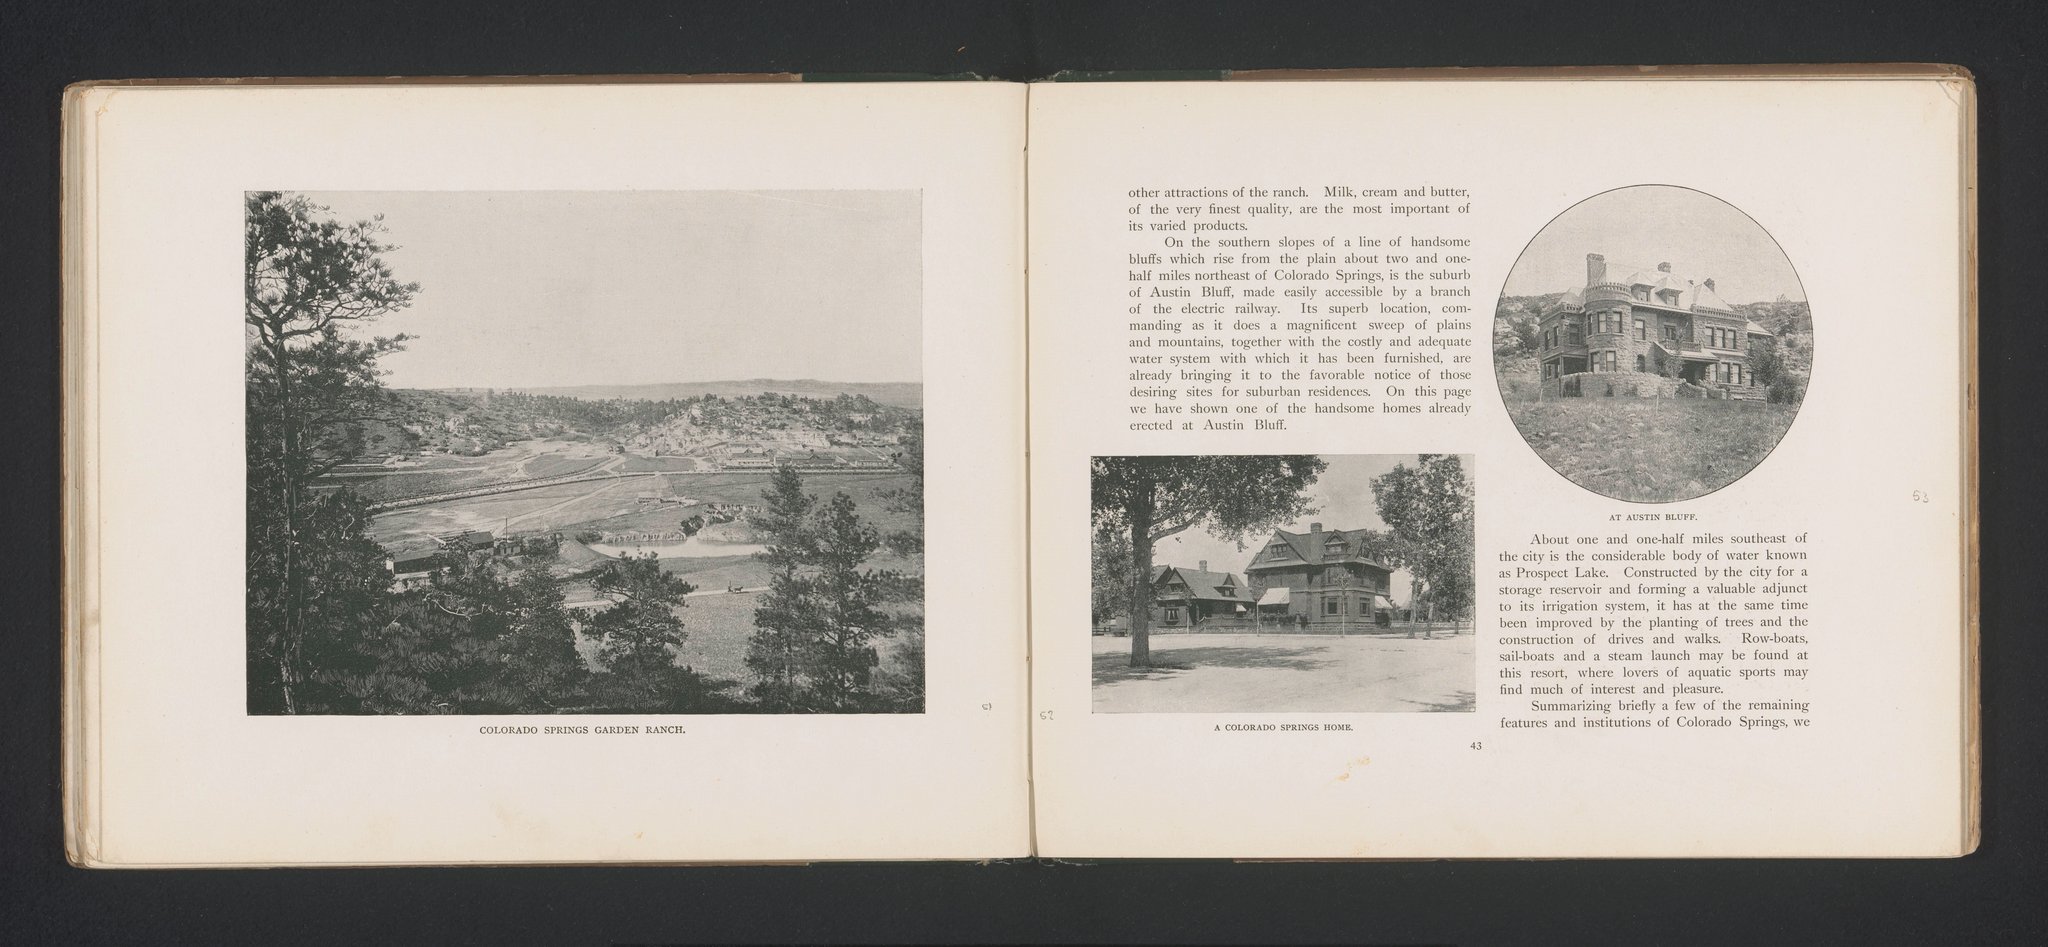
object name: page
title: At Austin Bluff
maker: Anonymous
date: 1888-1893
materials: paper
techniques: autotype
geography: new york city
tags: villa